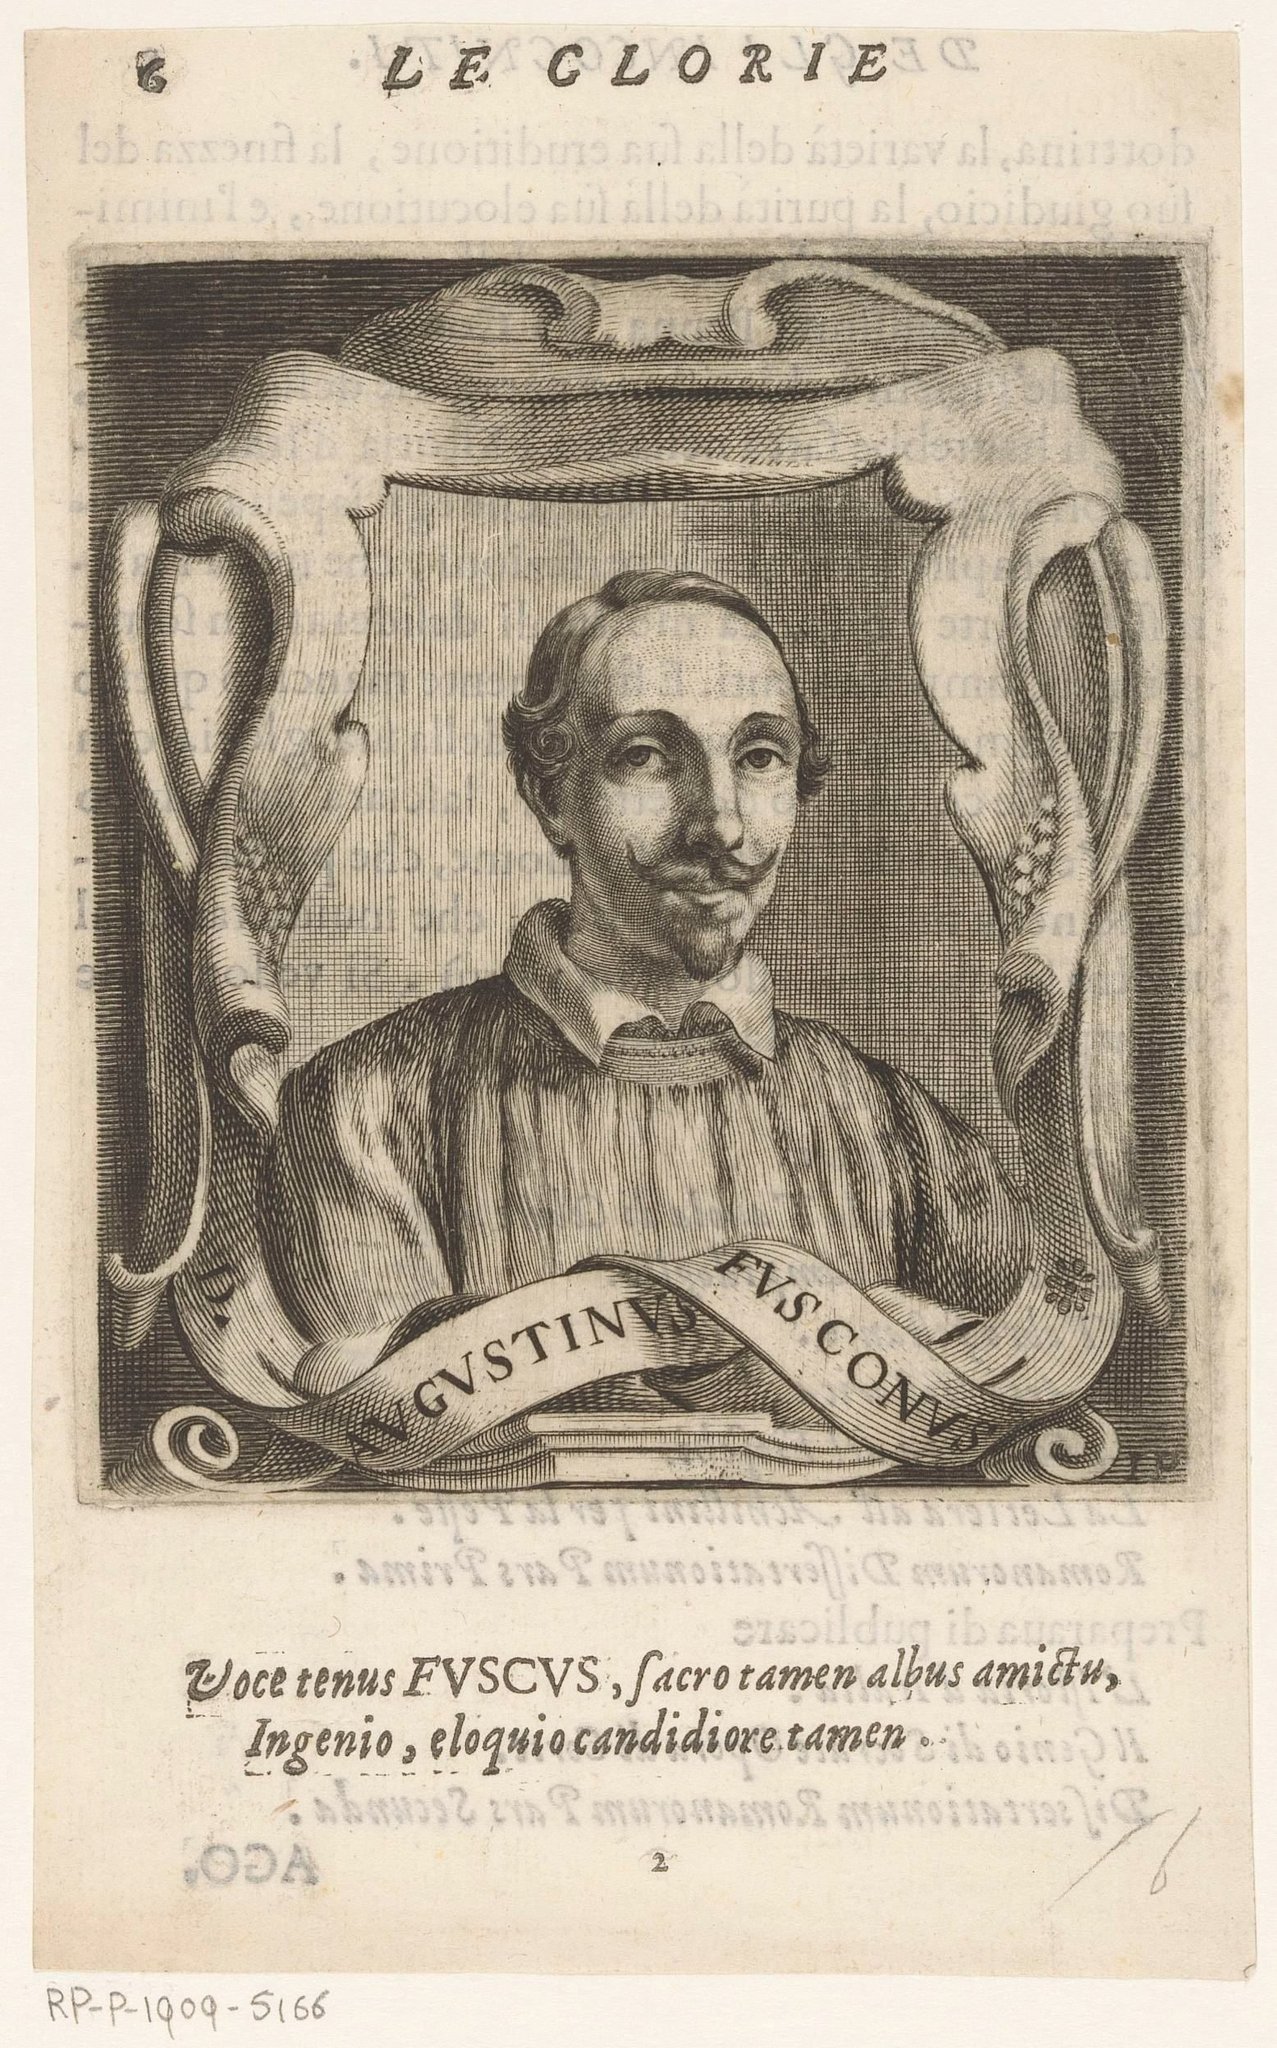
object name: book illustration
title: Portret van schrijver Agostino Fusconi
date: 1647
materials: paper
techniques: engraving, letterpress printing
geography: venice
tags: historical persons, portrait of a writer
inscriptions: collector's mark: Lugt 2228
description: Prent uit de publicatie: Loredan, Giovan Francesco. Le glorie degli Incogniti. Venetië: Francesco Valvasense, 1647, p. 6.